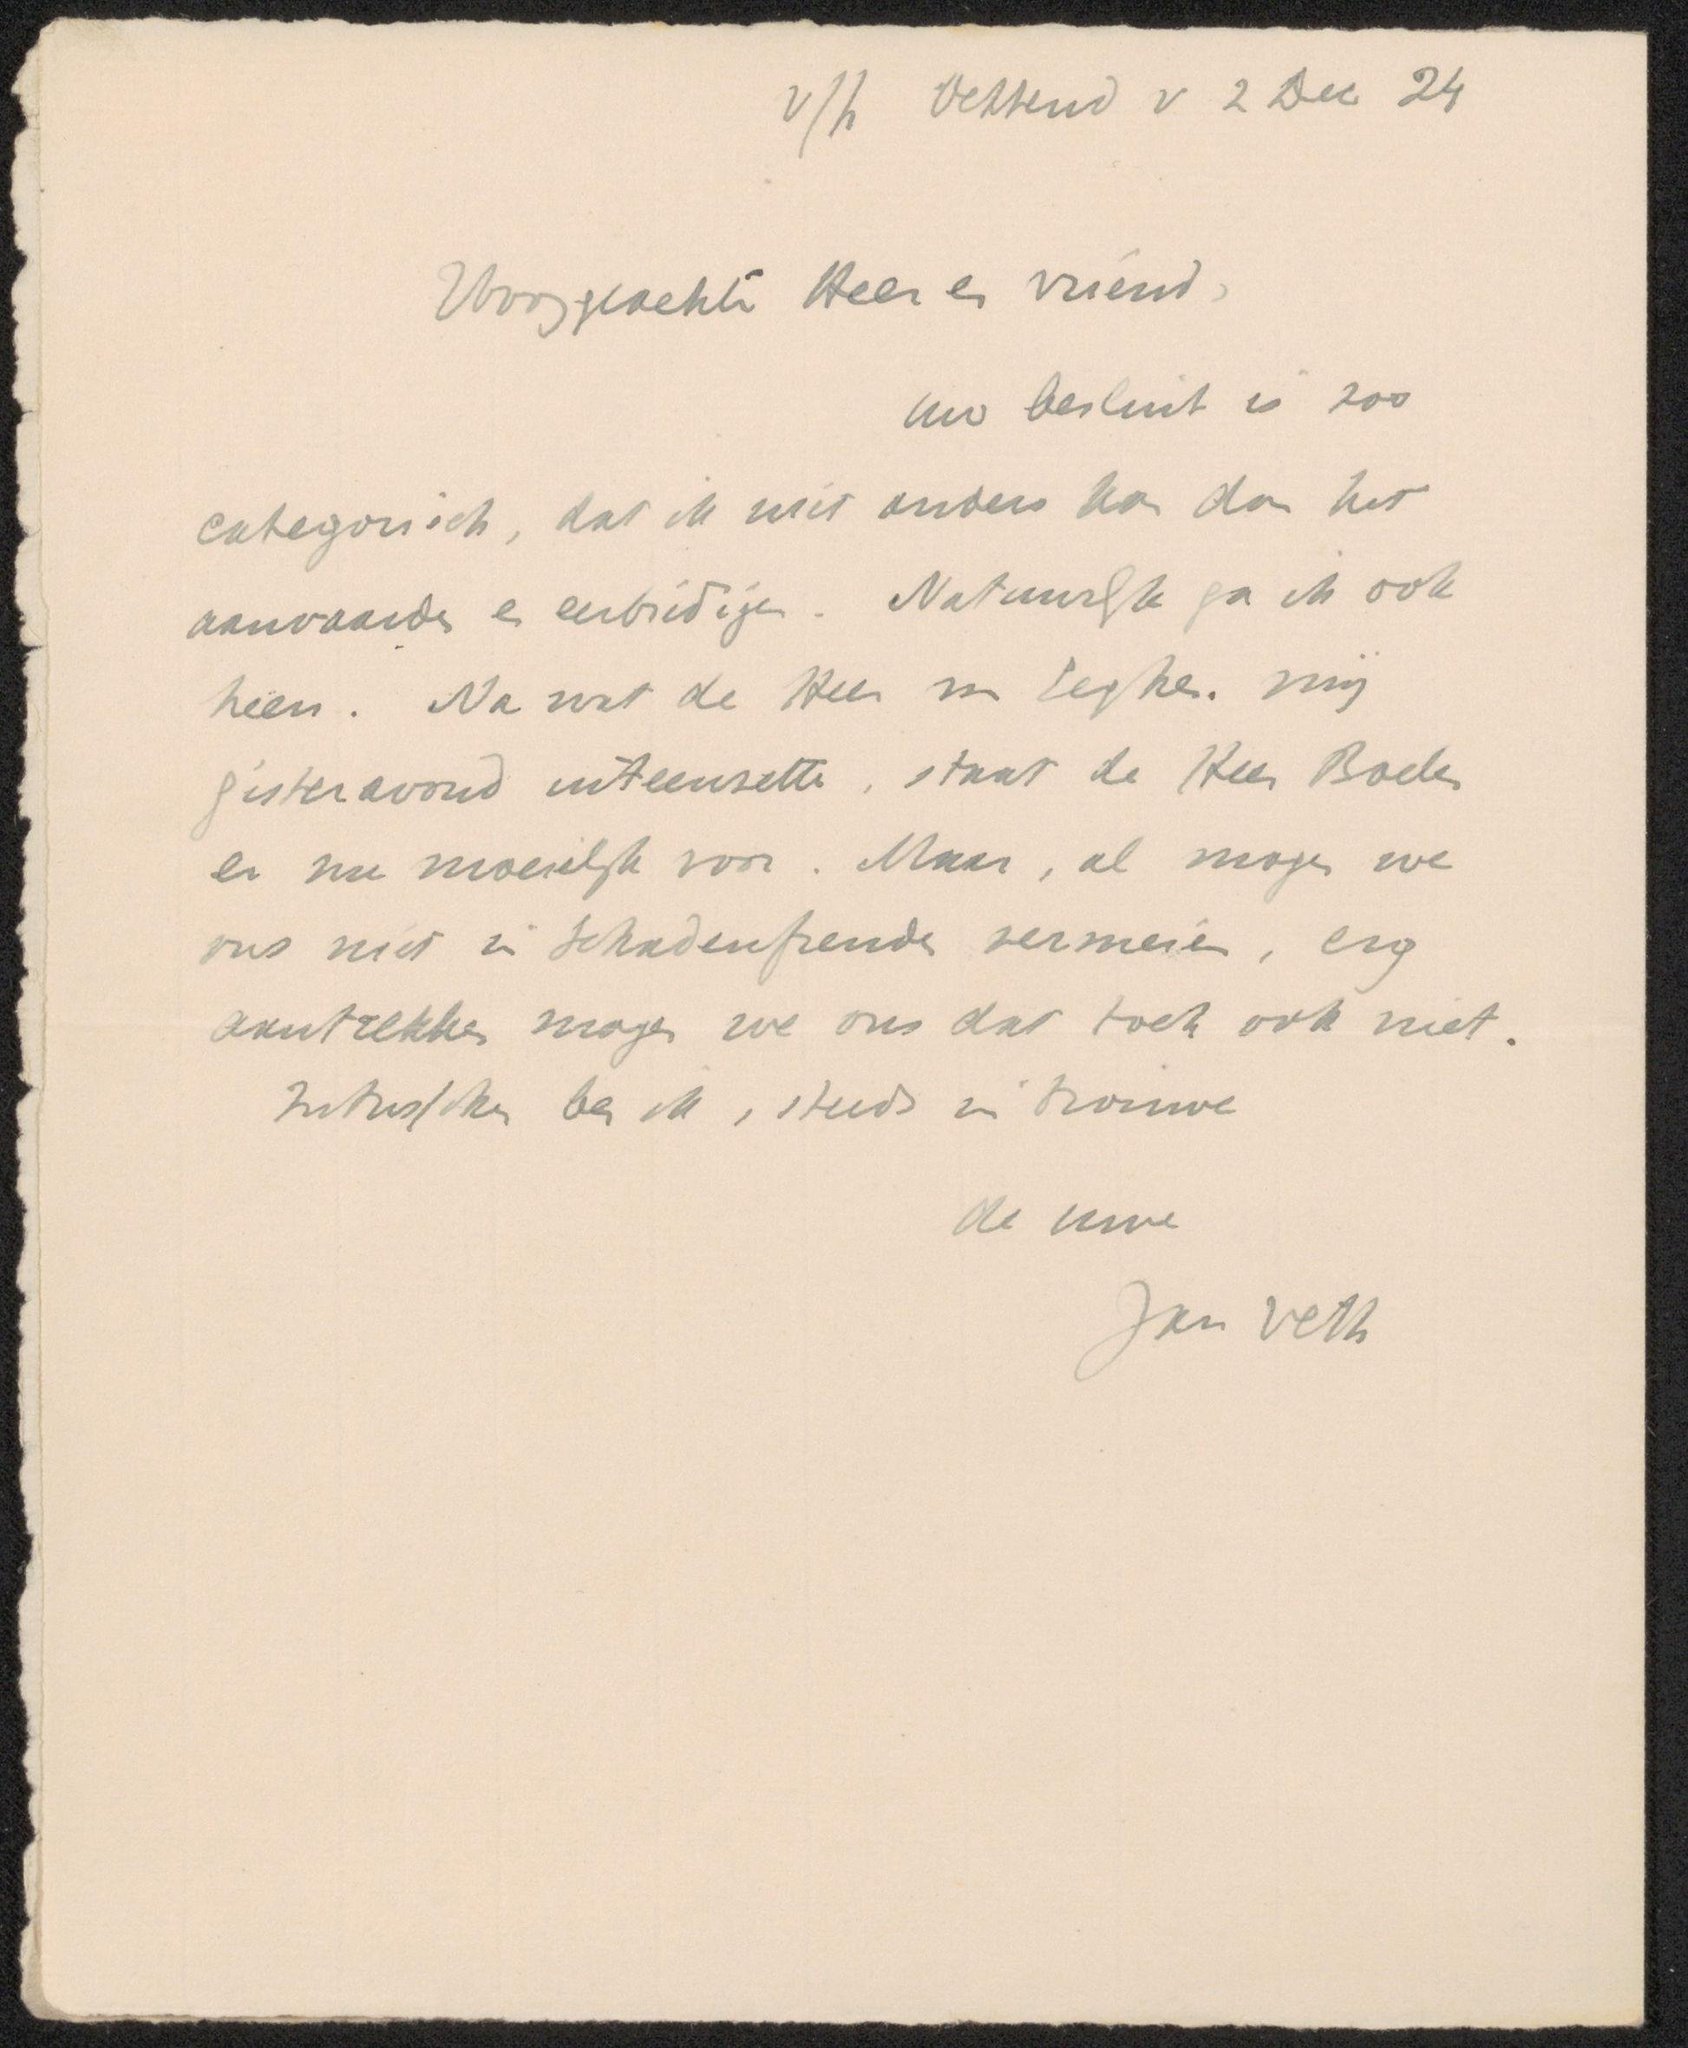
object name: letter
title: Brief aan F.E. Posthumus Meyjes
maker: jan veth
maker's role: designer, draughtsman, painter, print maker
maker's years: 1864-1925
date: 1924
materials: ink, paper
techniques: pen, writing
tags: f.e. posthumus meyjes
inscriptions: collector's mark: ‘RPK’